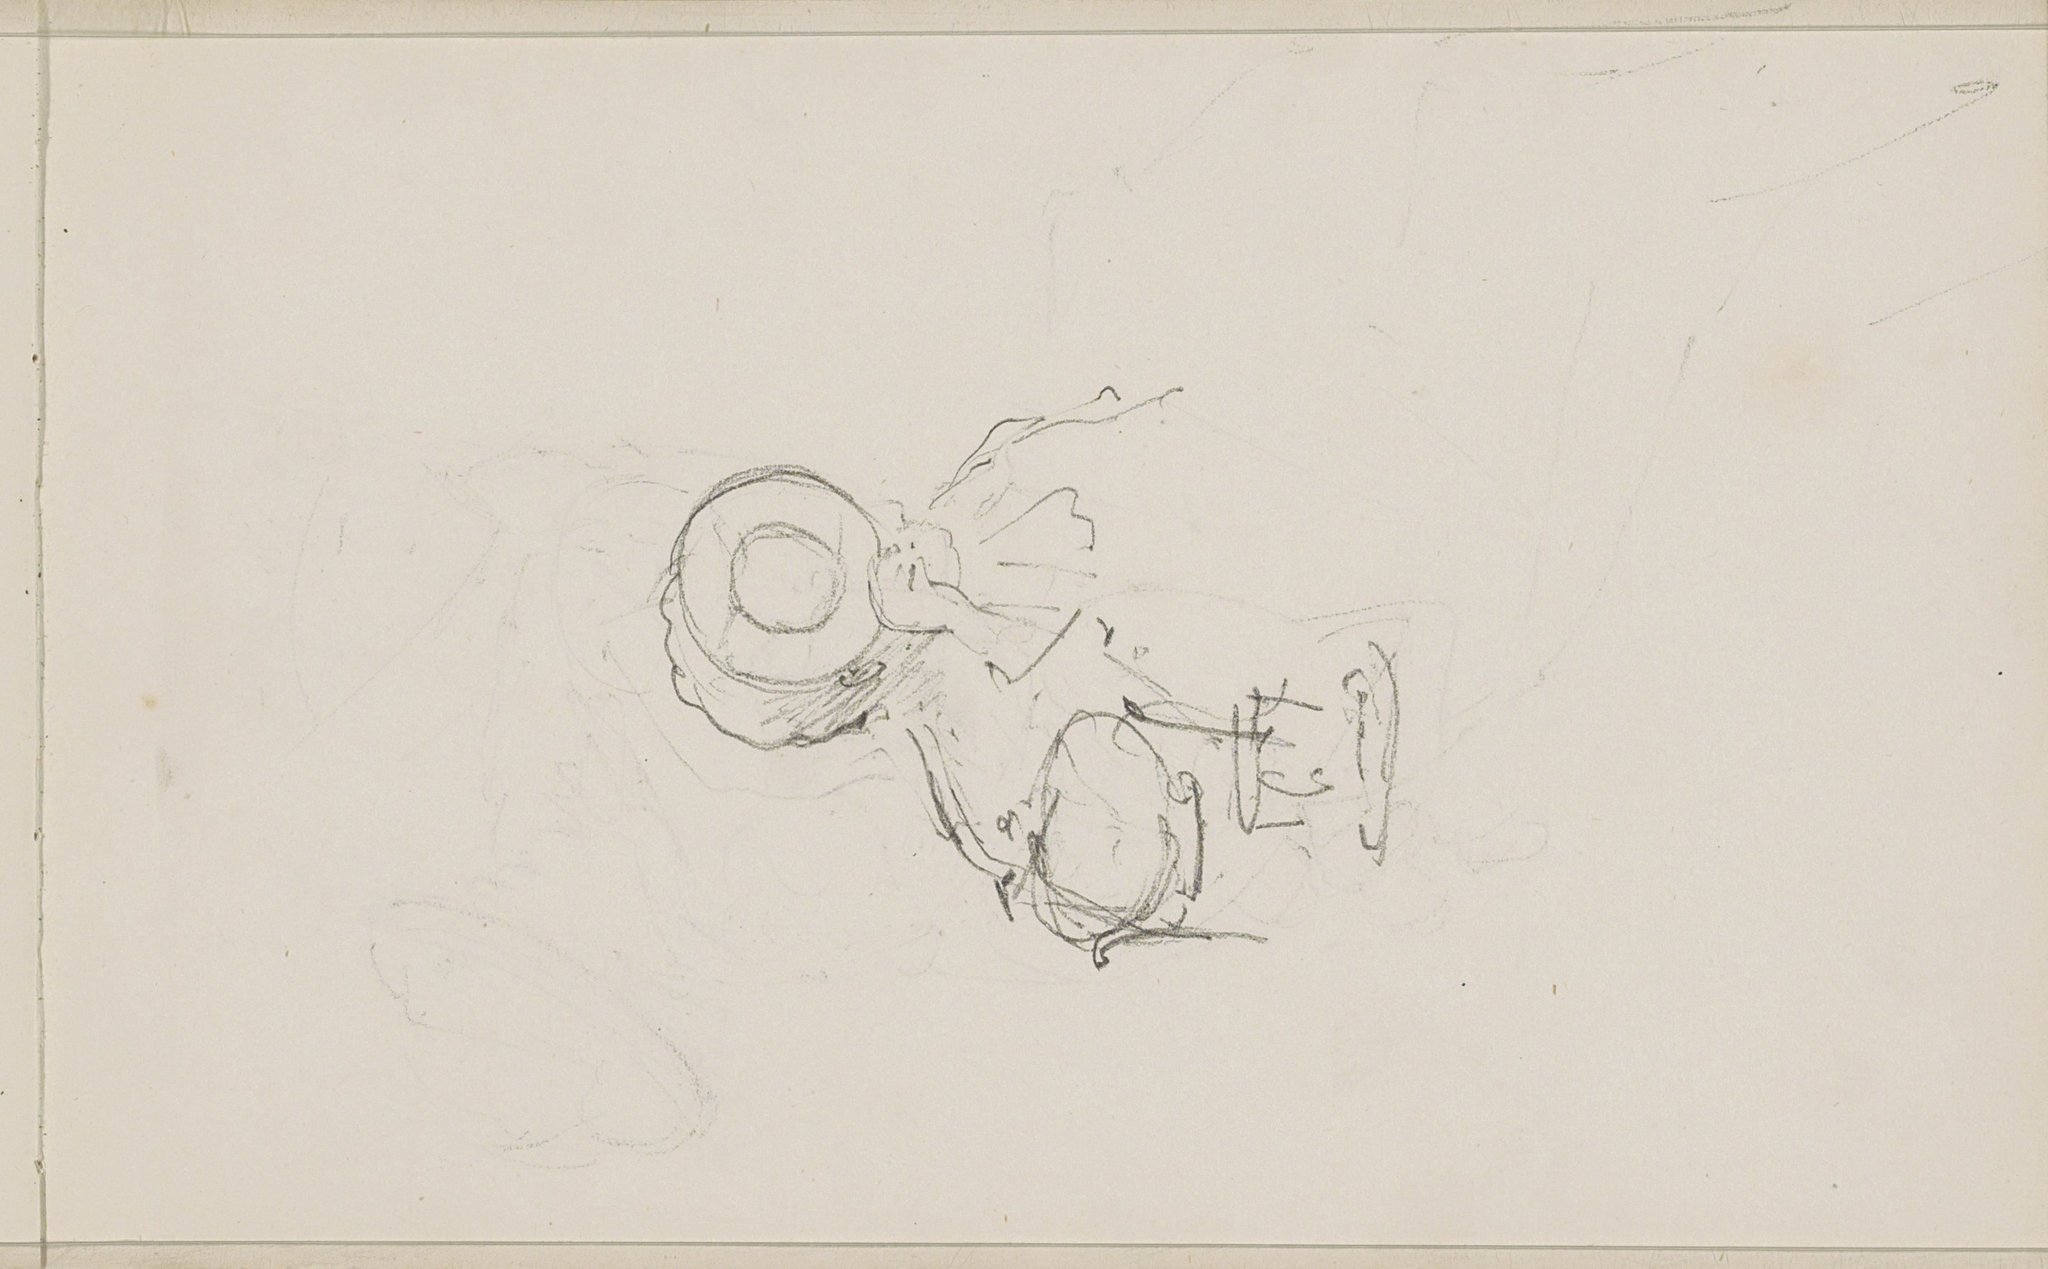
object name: sketchbook leaf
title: Vrouw die een hoed voor haar hoofd houdt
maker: a.a.l. de grammont-hubrecht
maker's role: draughtsman, painter, print maker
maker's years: 1855-1913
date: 1865-1913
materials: chalk, paper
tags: adult woman, head-gear: hat (+ women's clothes), tea-pot; samovar, cup and saucer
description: Tevens een studie van een theepot en een kop en schotel. Blad 5 recto uit een schetsboek met 28 bladen.